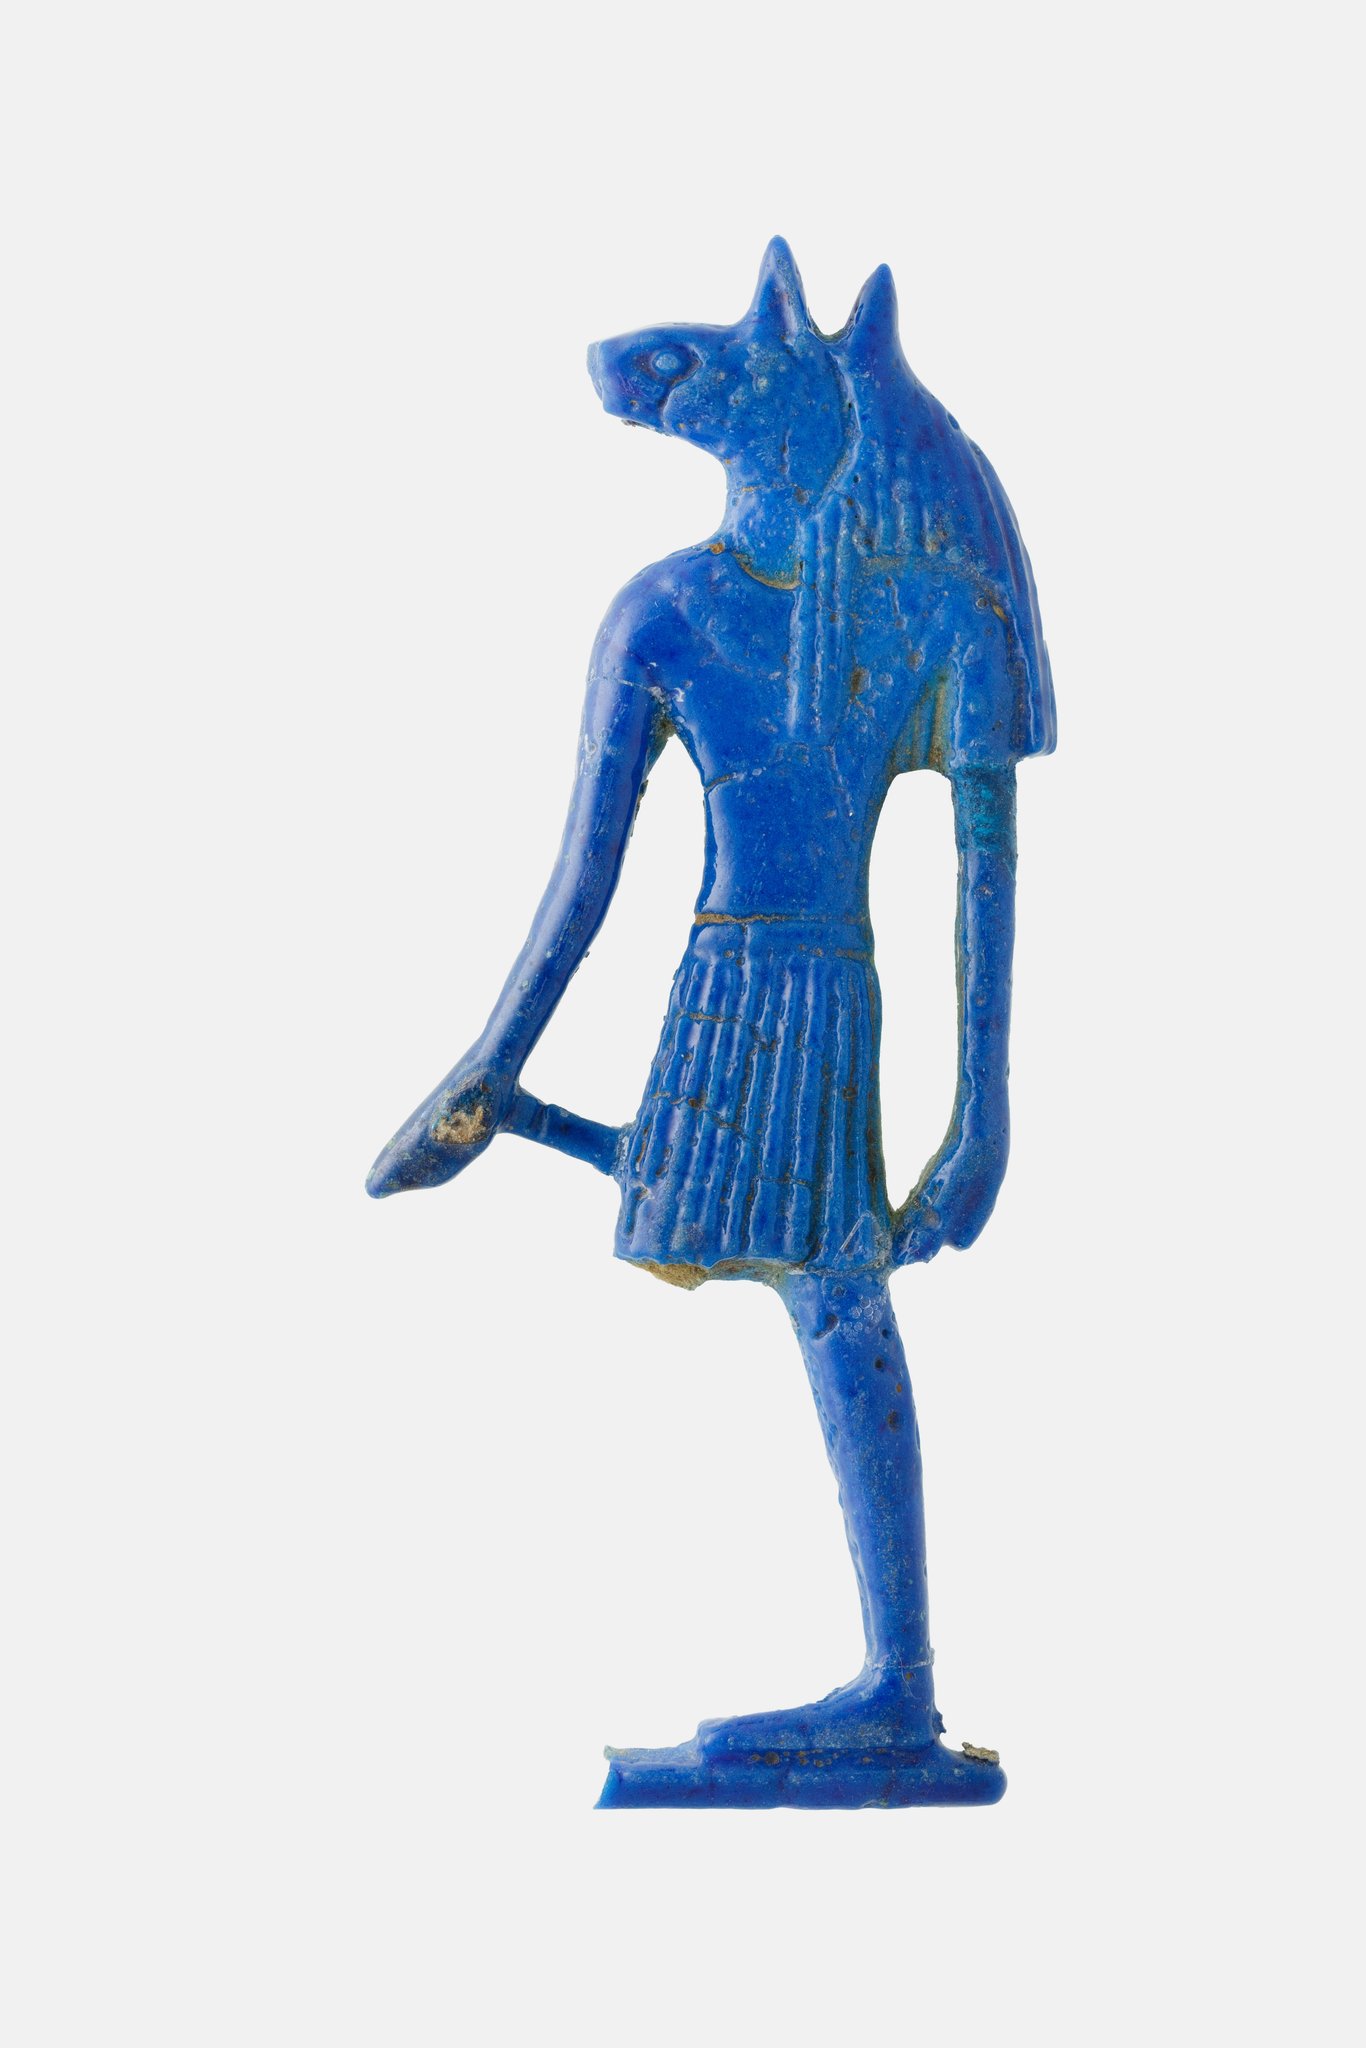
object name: inlay, hieroglyph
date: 664-610 BCE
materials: faience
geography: egypt